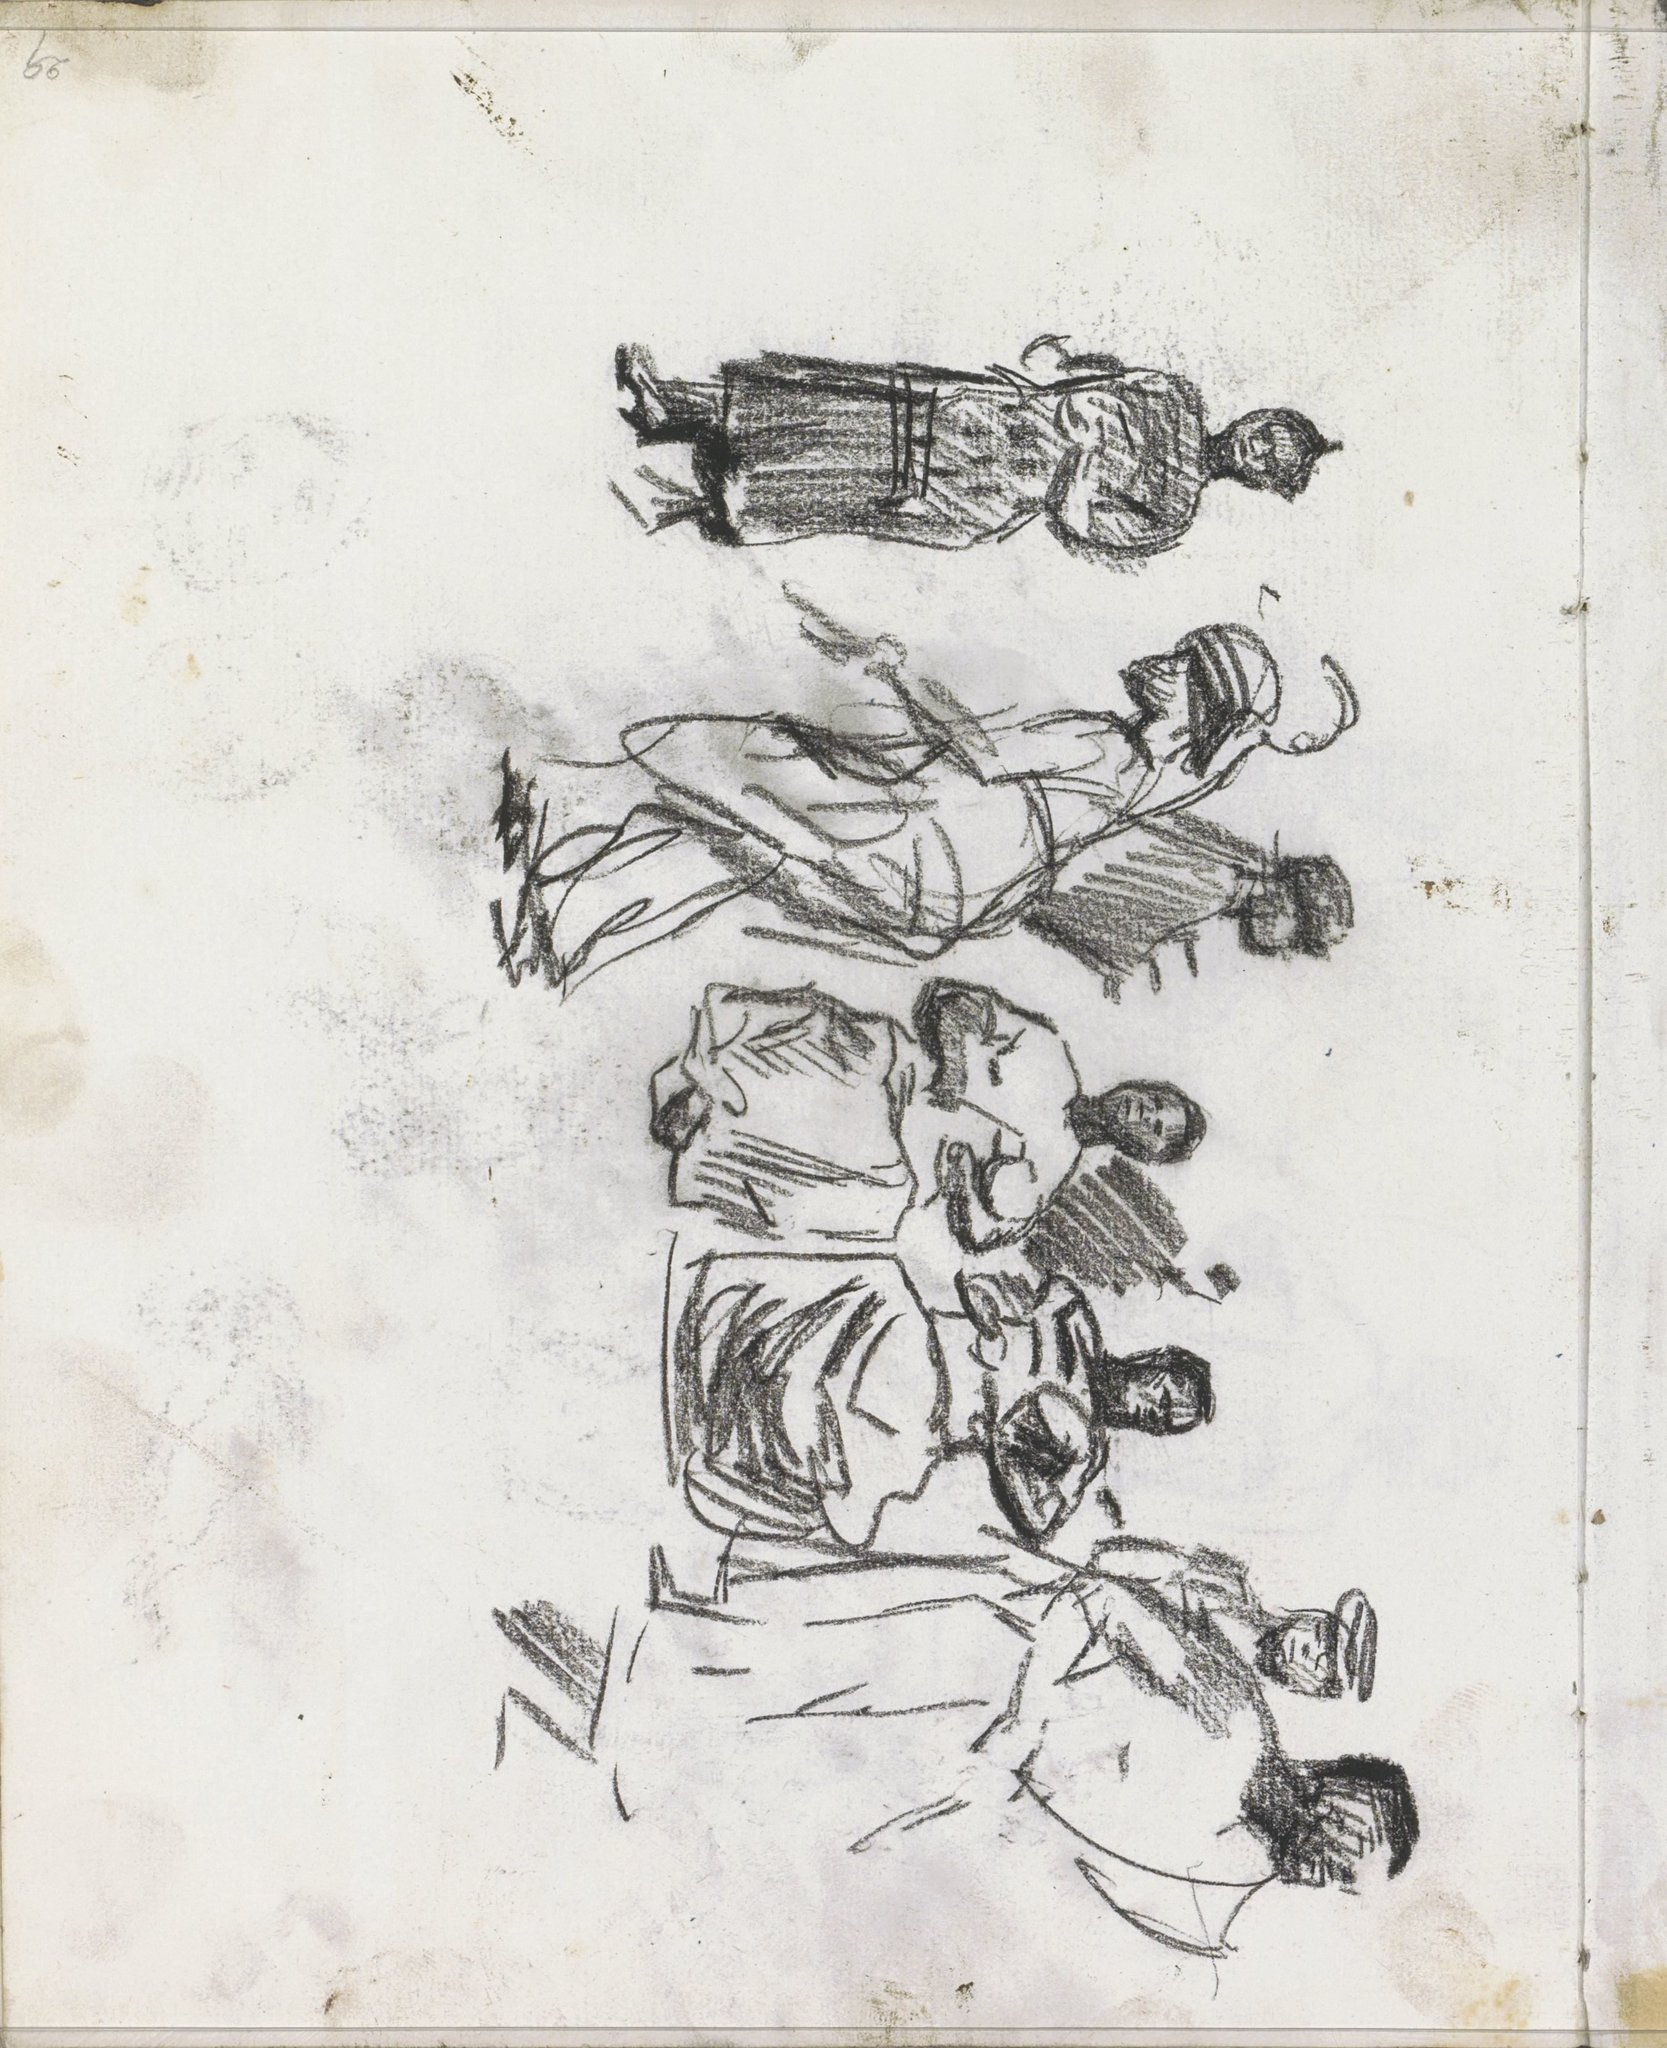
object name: sketchbook leaf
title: Staande figuren voor muzikanten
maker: isaac israels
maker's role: draughtsman, painter, print maker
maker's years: 1865-1934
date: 1875-1934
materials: chalk, paper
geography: the hague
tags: musician at work, standing figure, africans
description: Mogelijk Afrikanen. Blad 22 verso uit schetsboek XIII met 25 bladen.